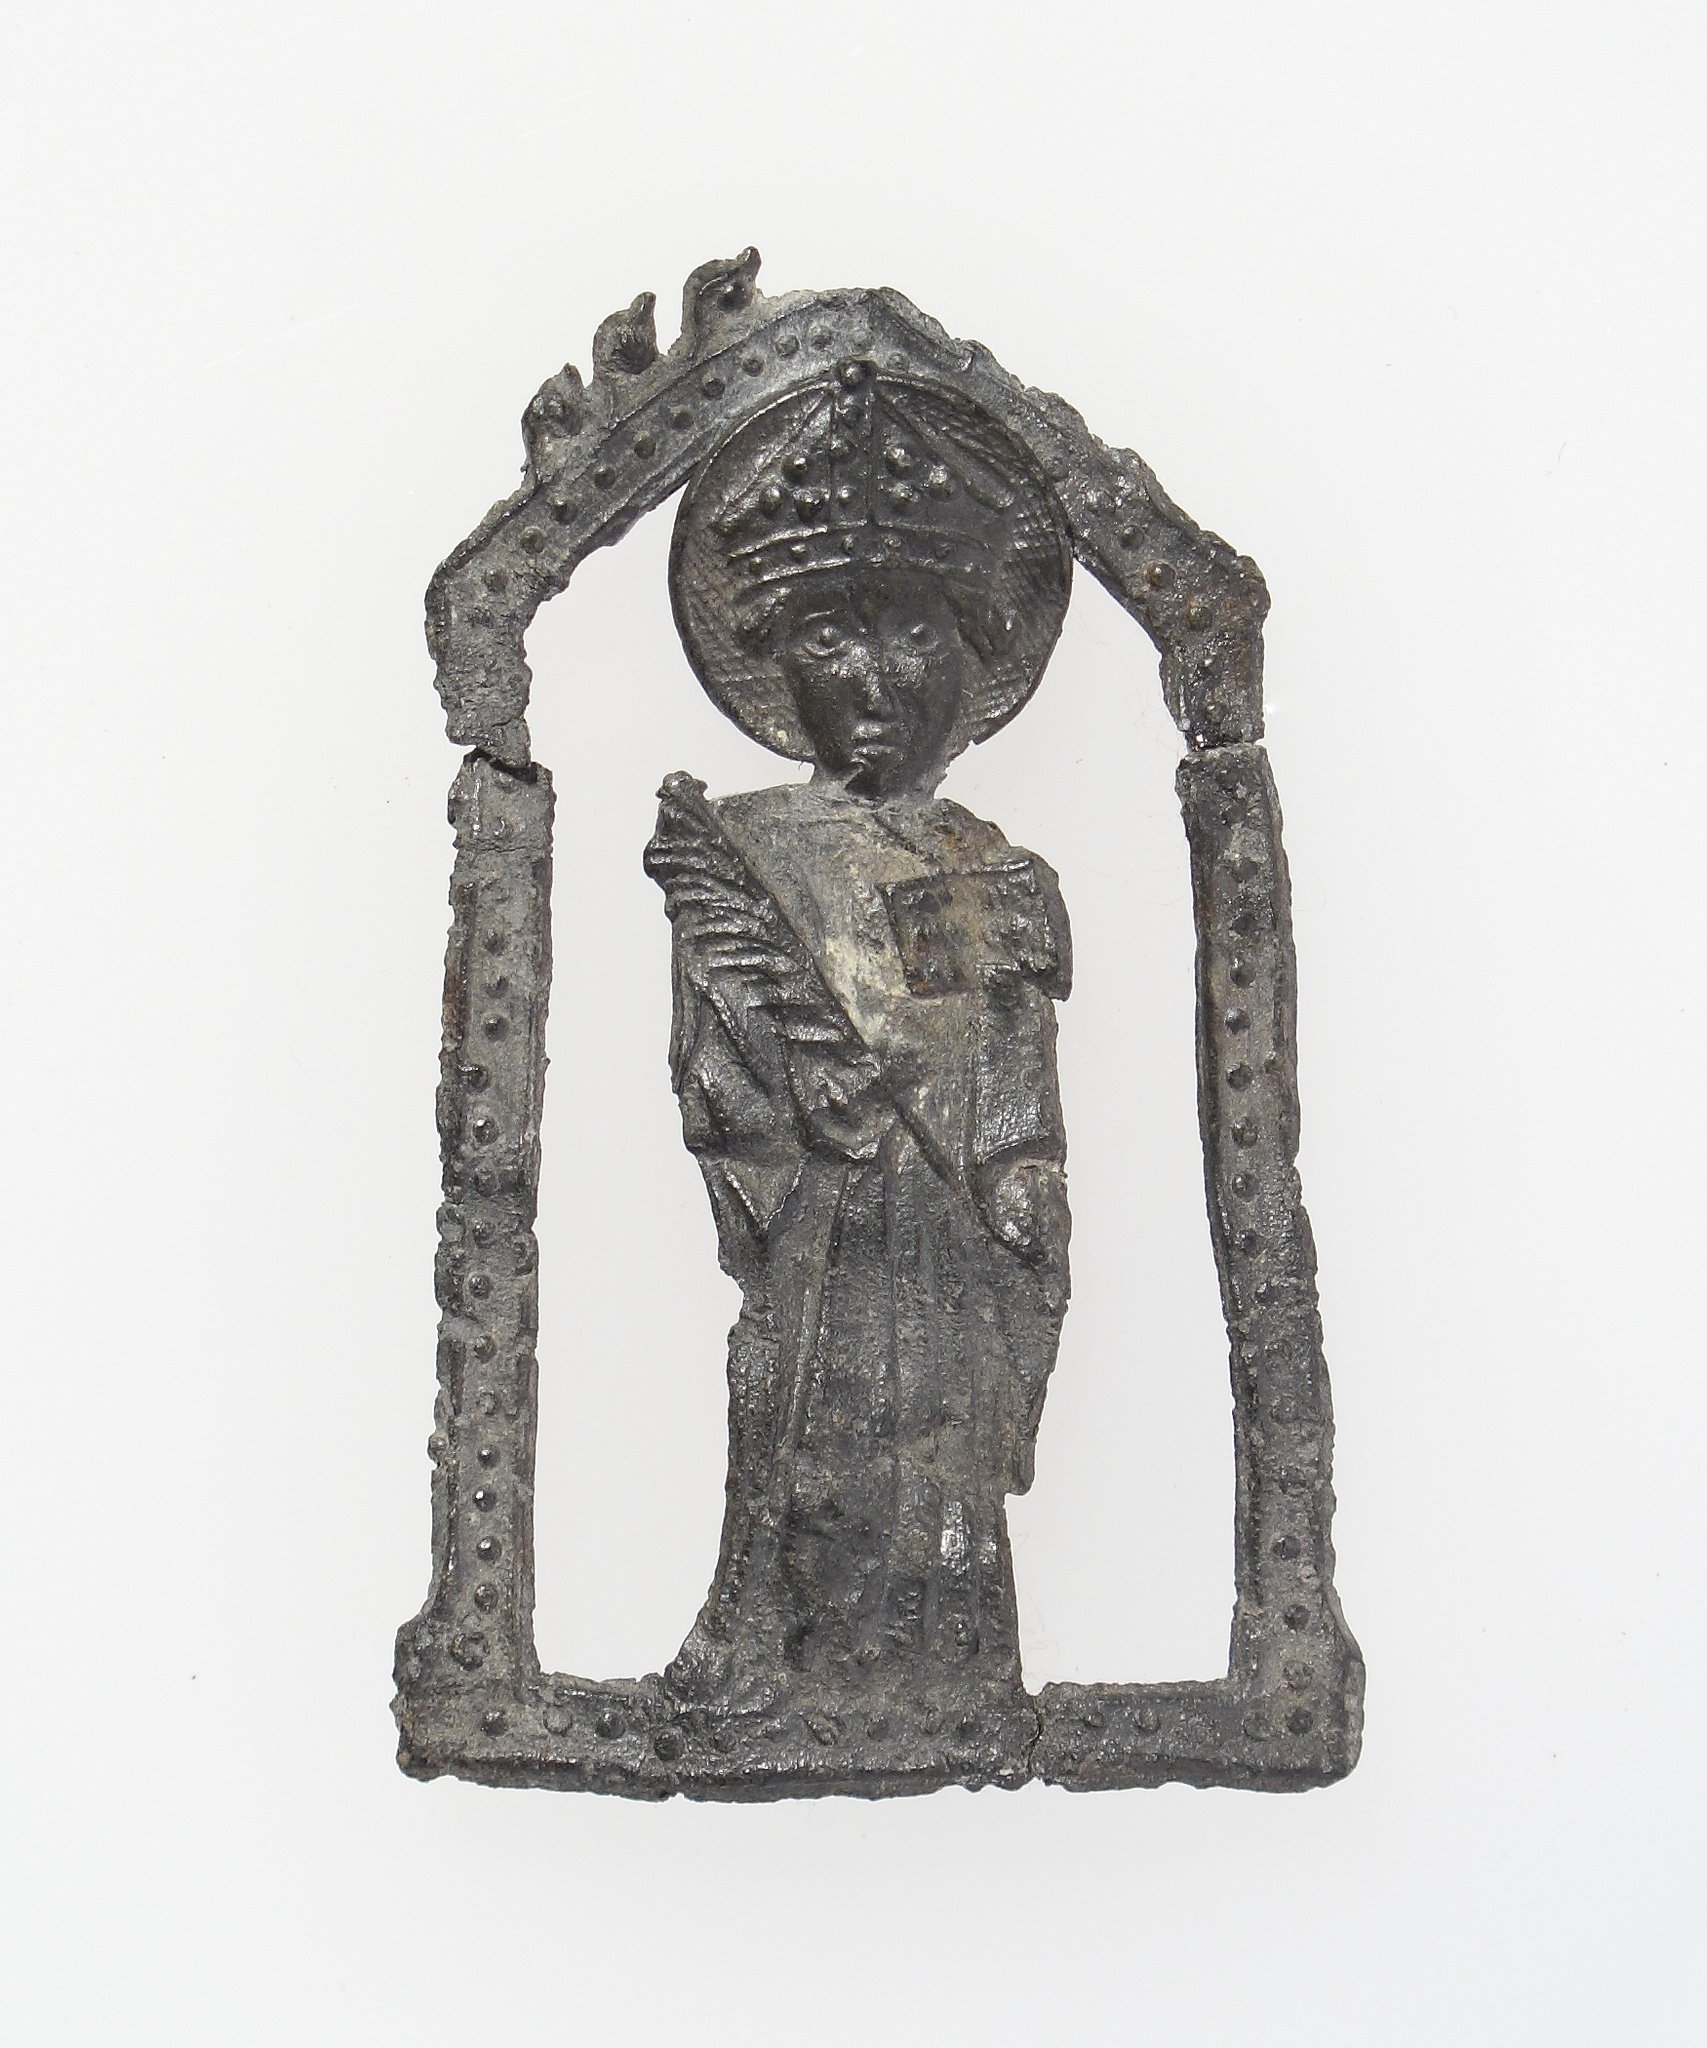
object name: pilgrim's badge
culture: french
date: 1301-1600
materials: lead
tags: saints